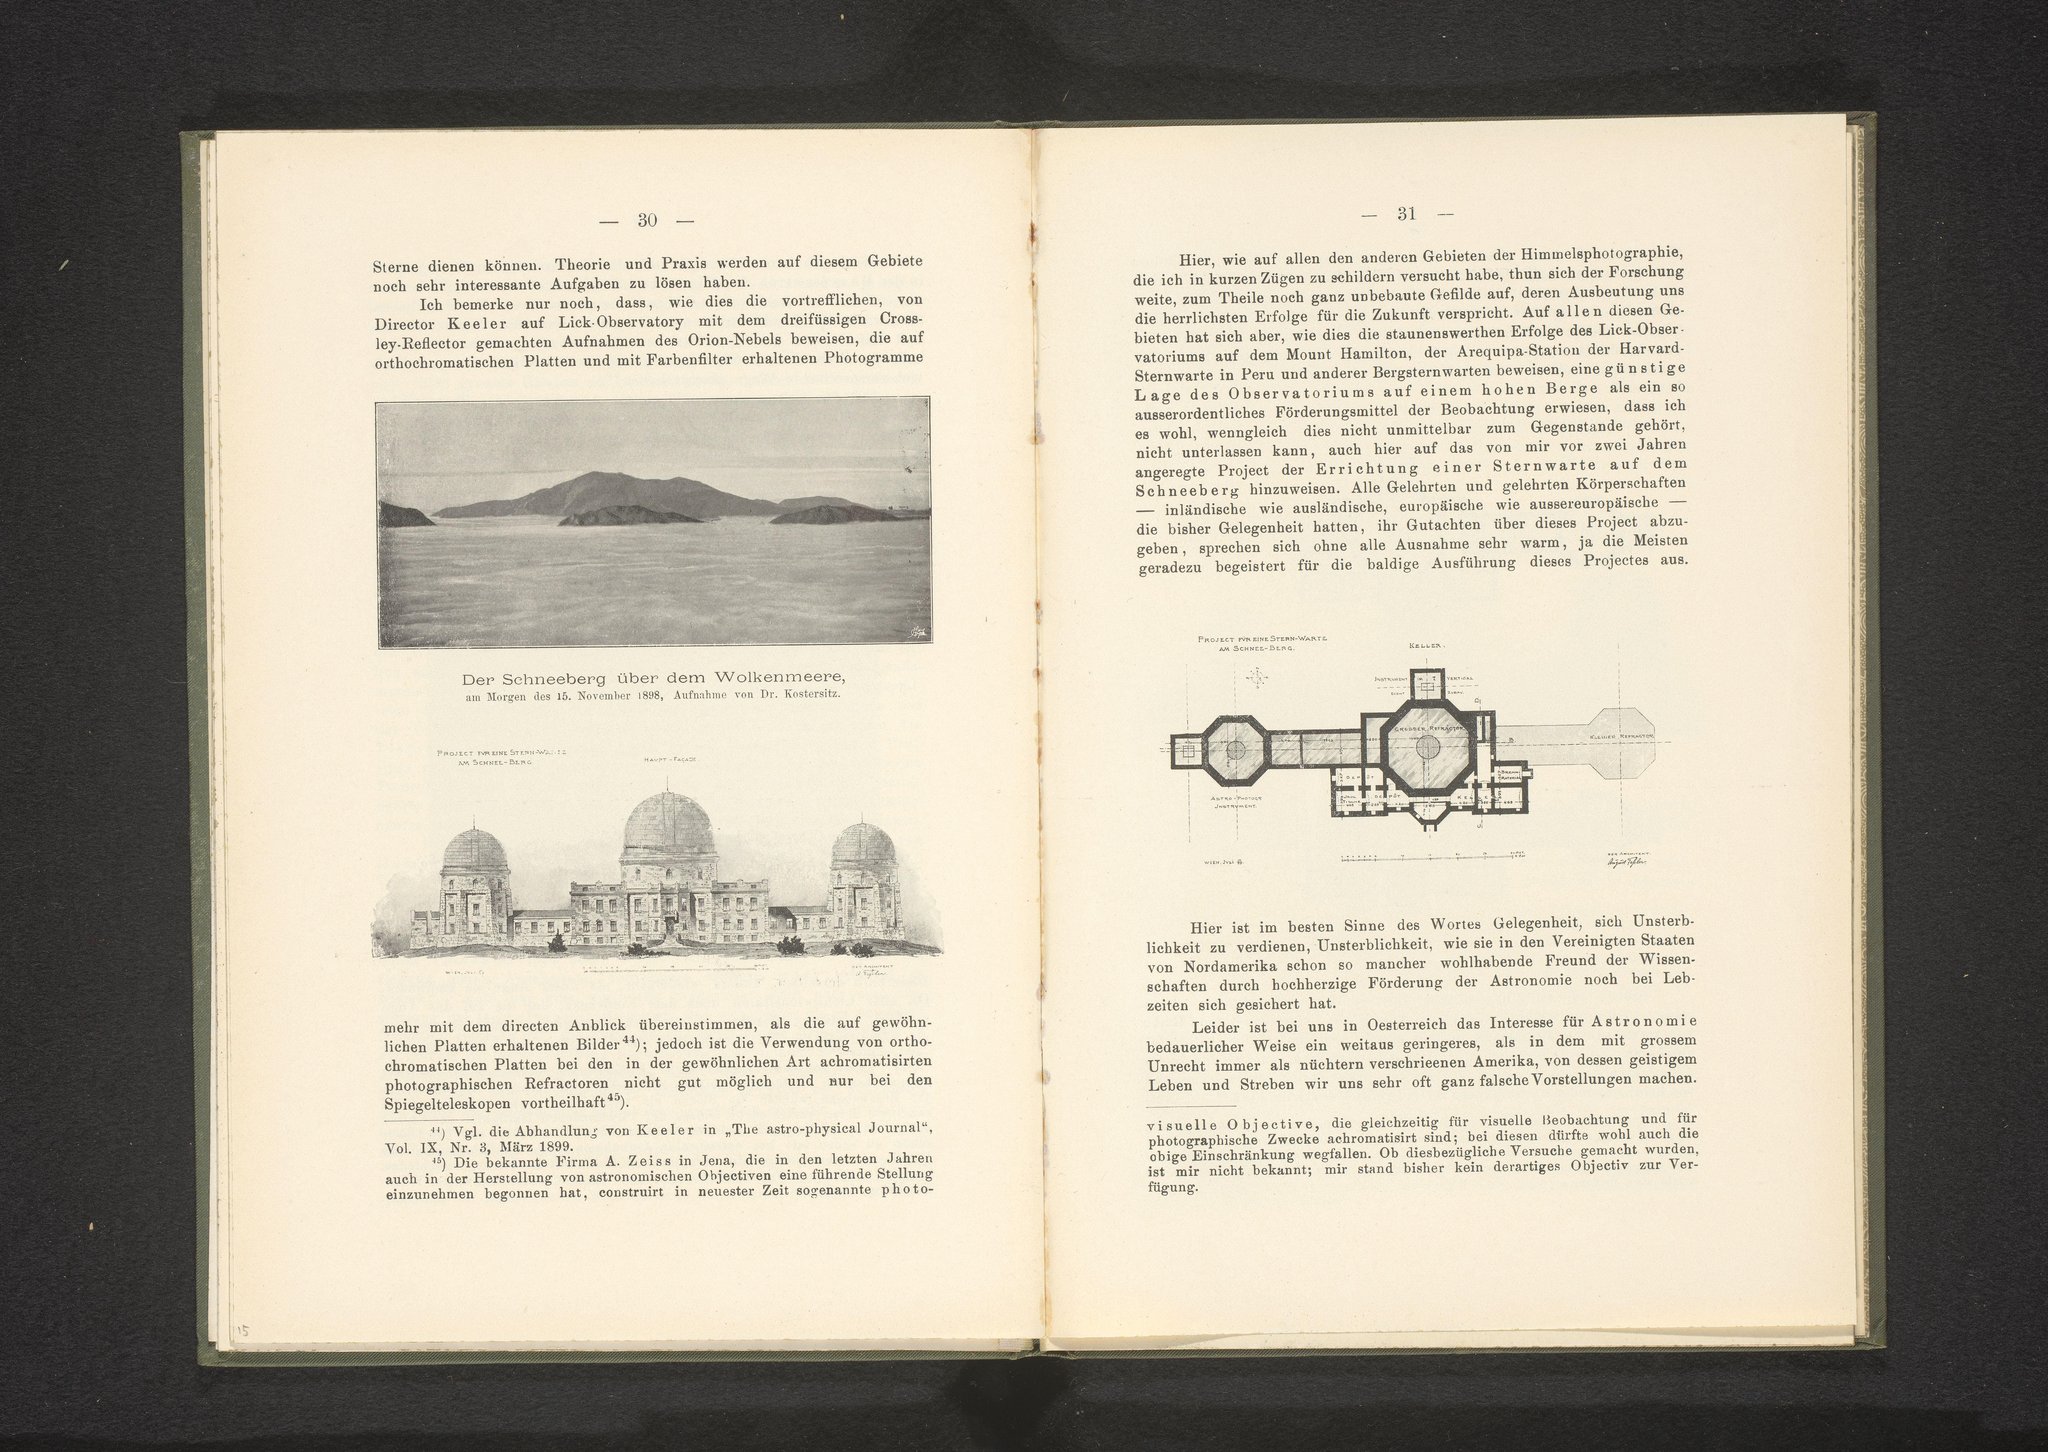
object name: page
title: Zevengesternte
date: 1887-1897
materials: paper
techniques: autotype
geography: vienna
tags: stars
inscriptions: inscription: ‘Extrafocale Aufnahme (29 mm ausserhalb der Brennebene) von Dr. Karl Schwarzschild, v. Kuffner'sche Sternwarte, Wien-Ottakring.’